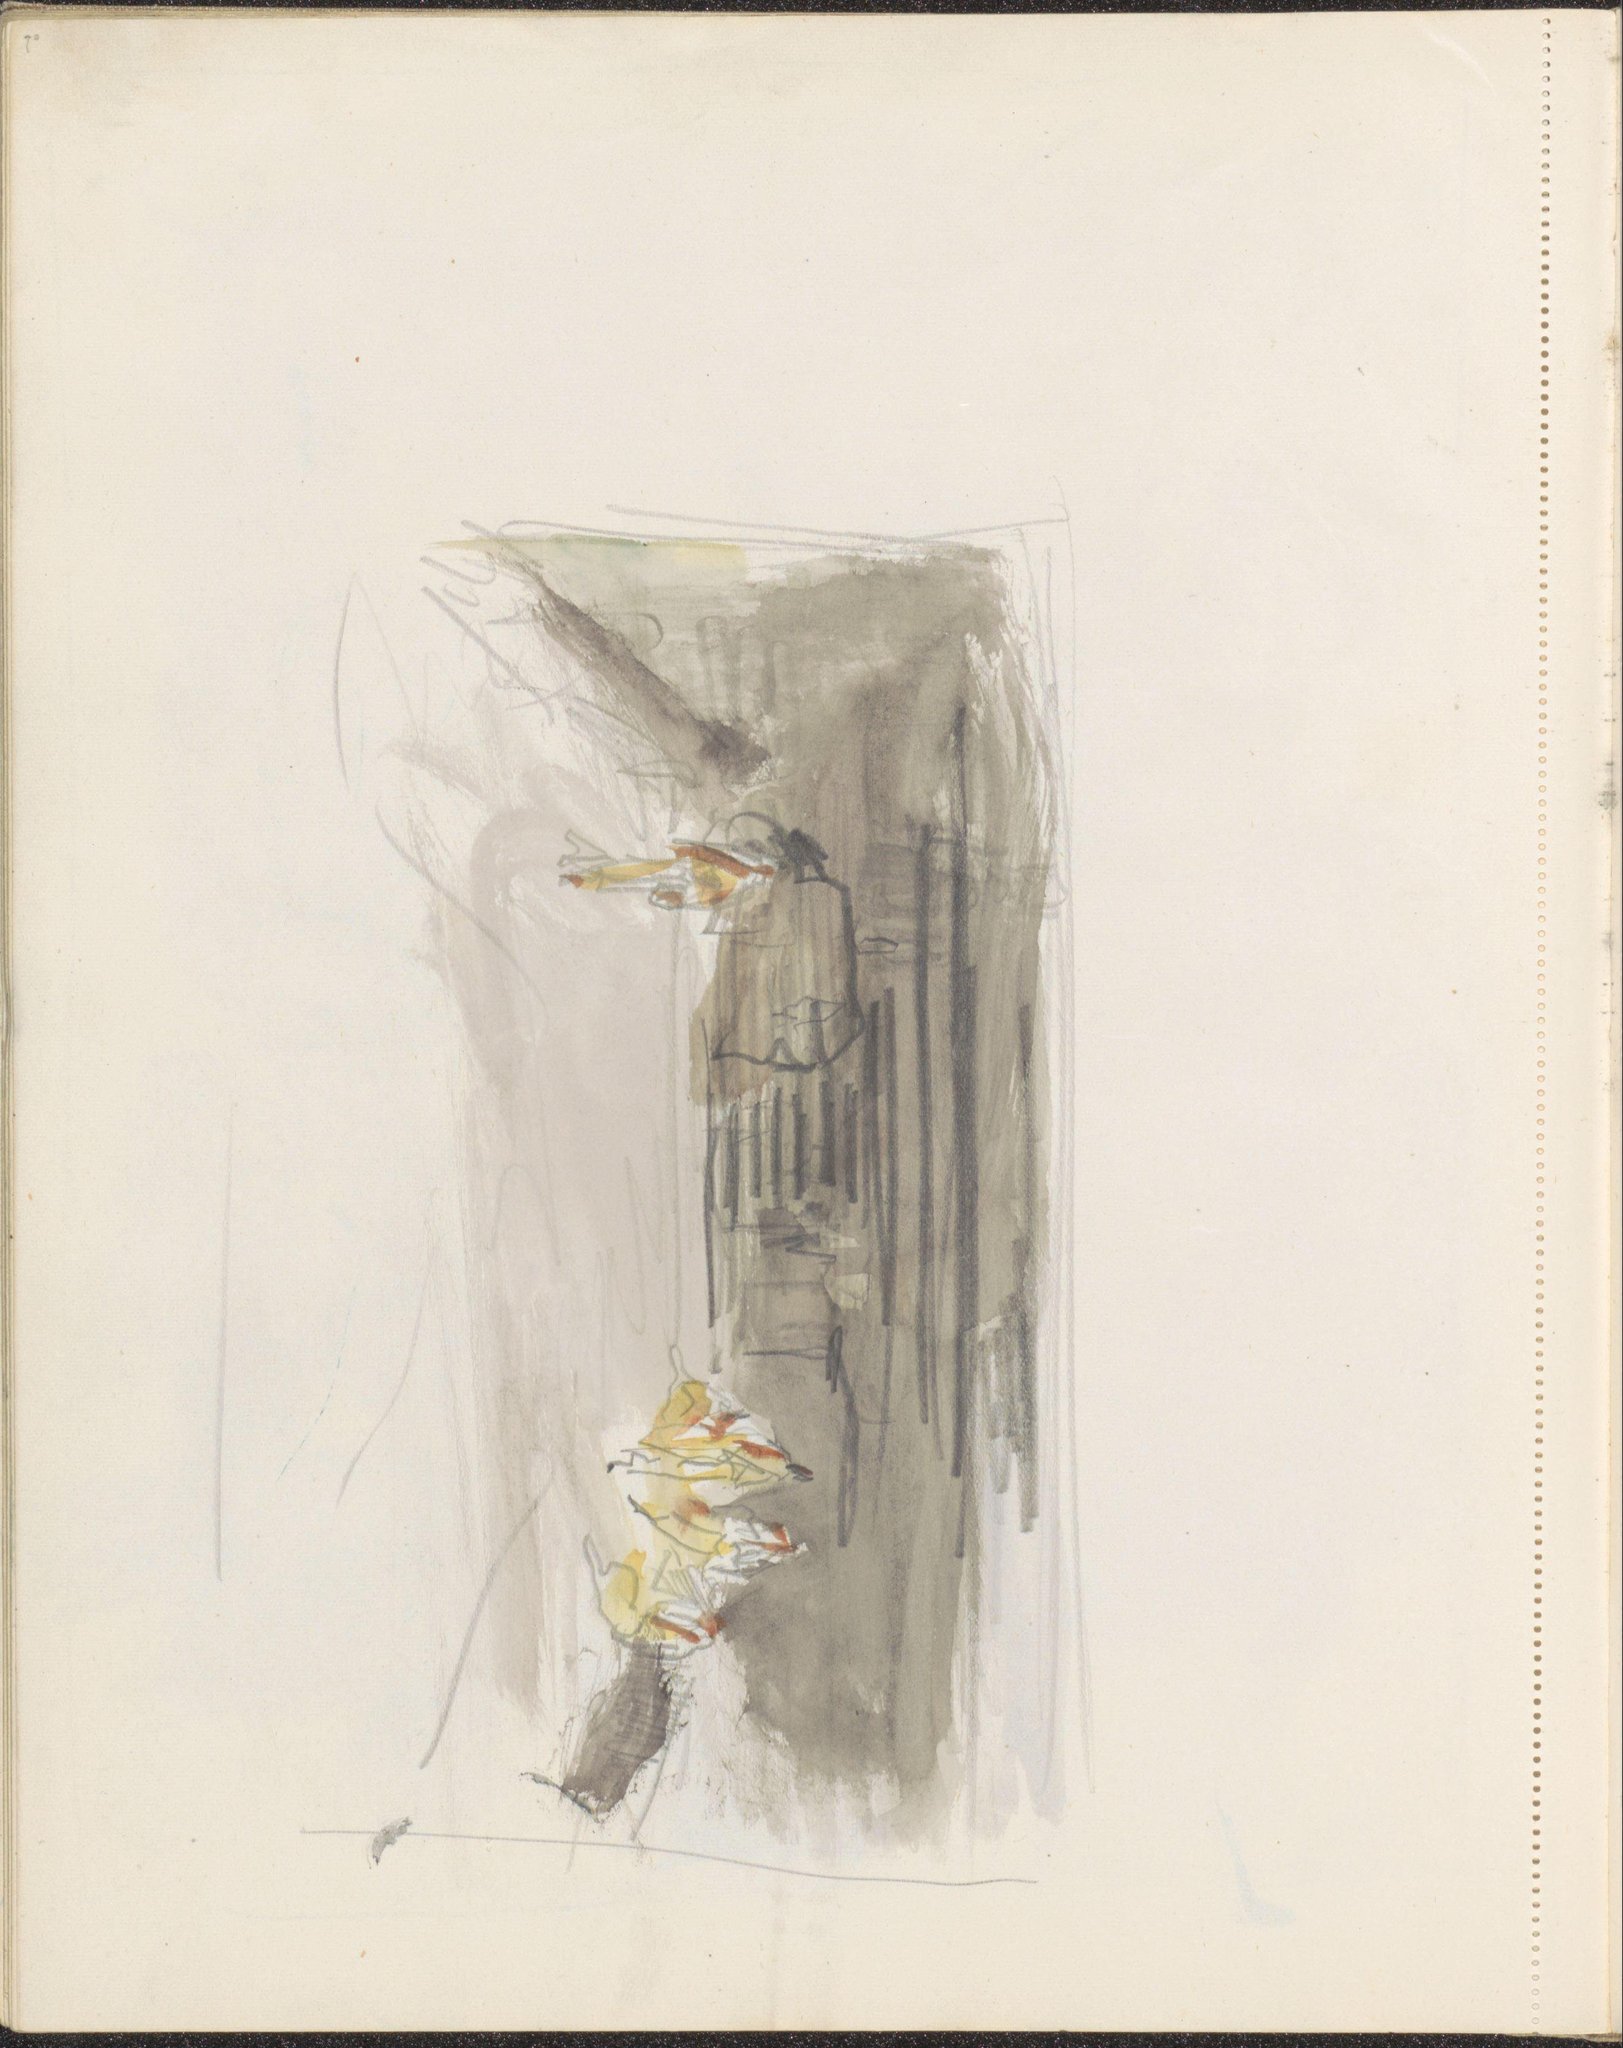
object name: sketchbook leaf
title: Boeddhistische monniken bij de opgang van een trap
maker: marius bauer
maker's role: draughtsman, print maker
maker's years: 1867-1932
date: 1931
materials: paper, pencil, watercolor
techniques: brush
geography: cambodia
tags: flight of steps, religious functionaries ~ hinduism, buddhism, jainism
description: Mogelijk de trap van de Angkor Wat tempel in Cambodja. Pagina 70 uit een schetsboek met 48 bladen.